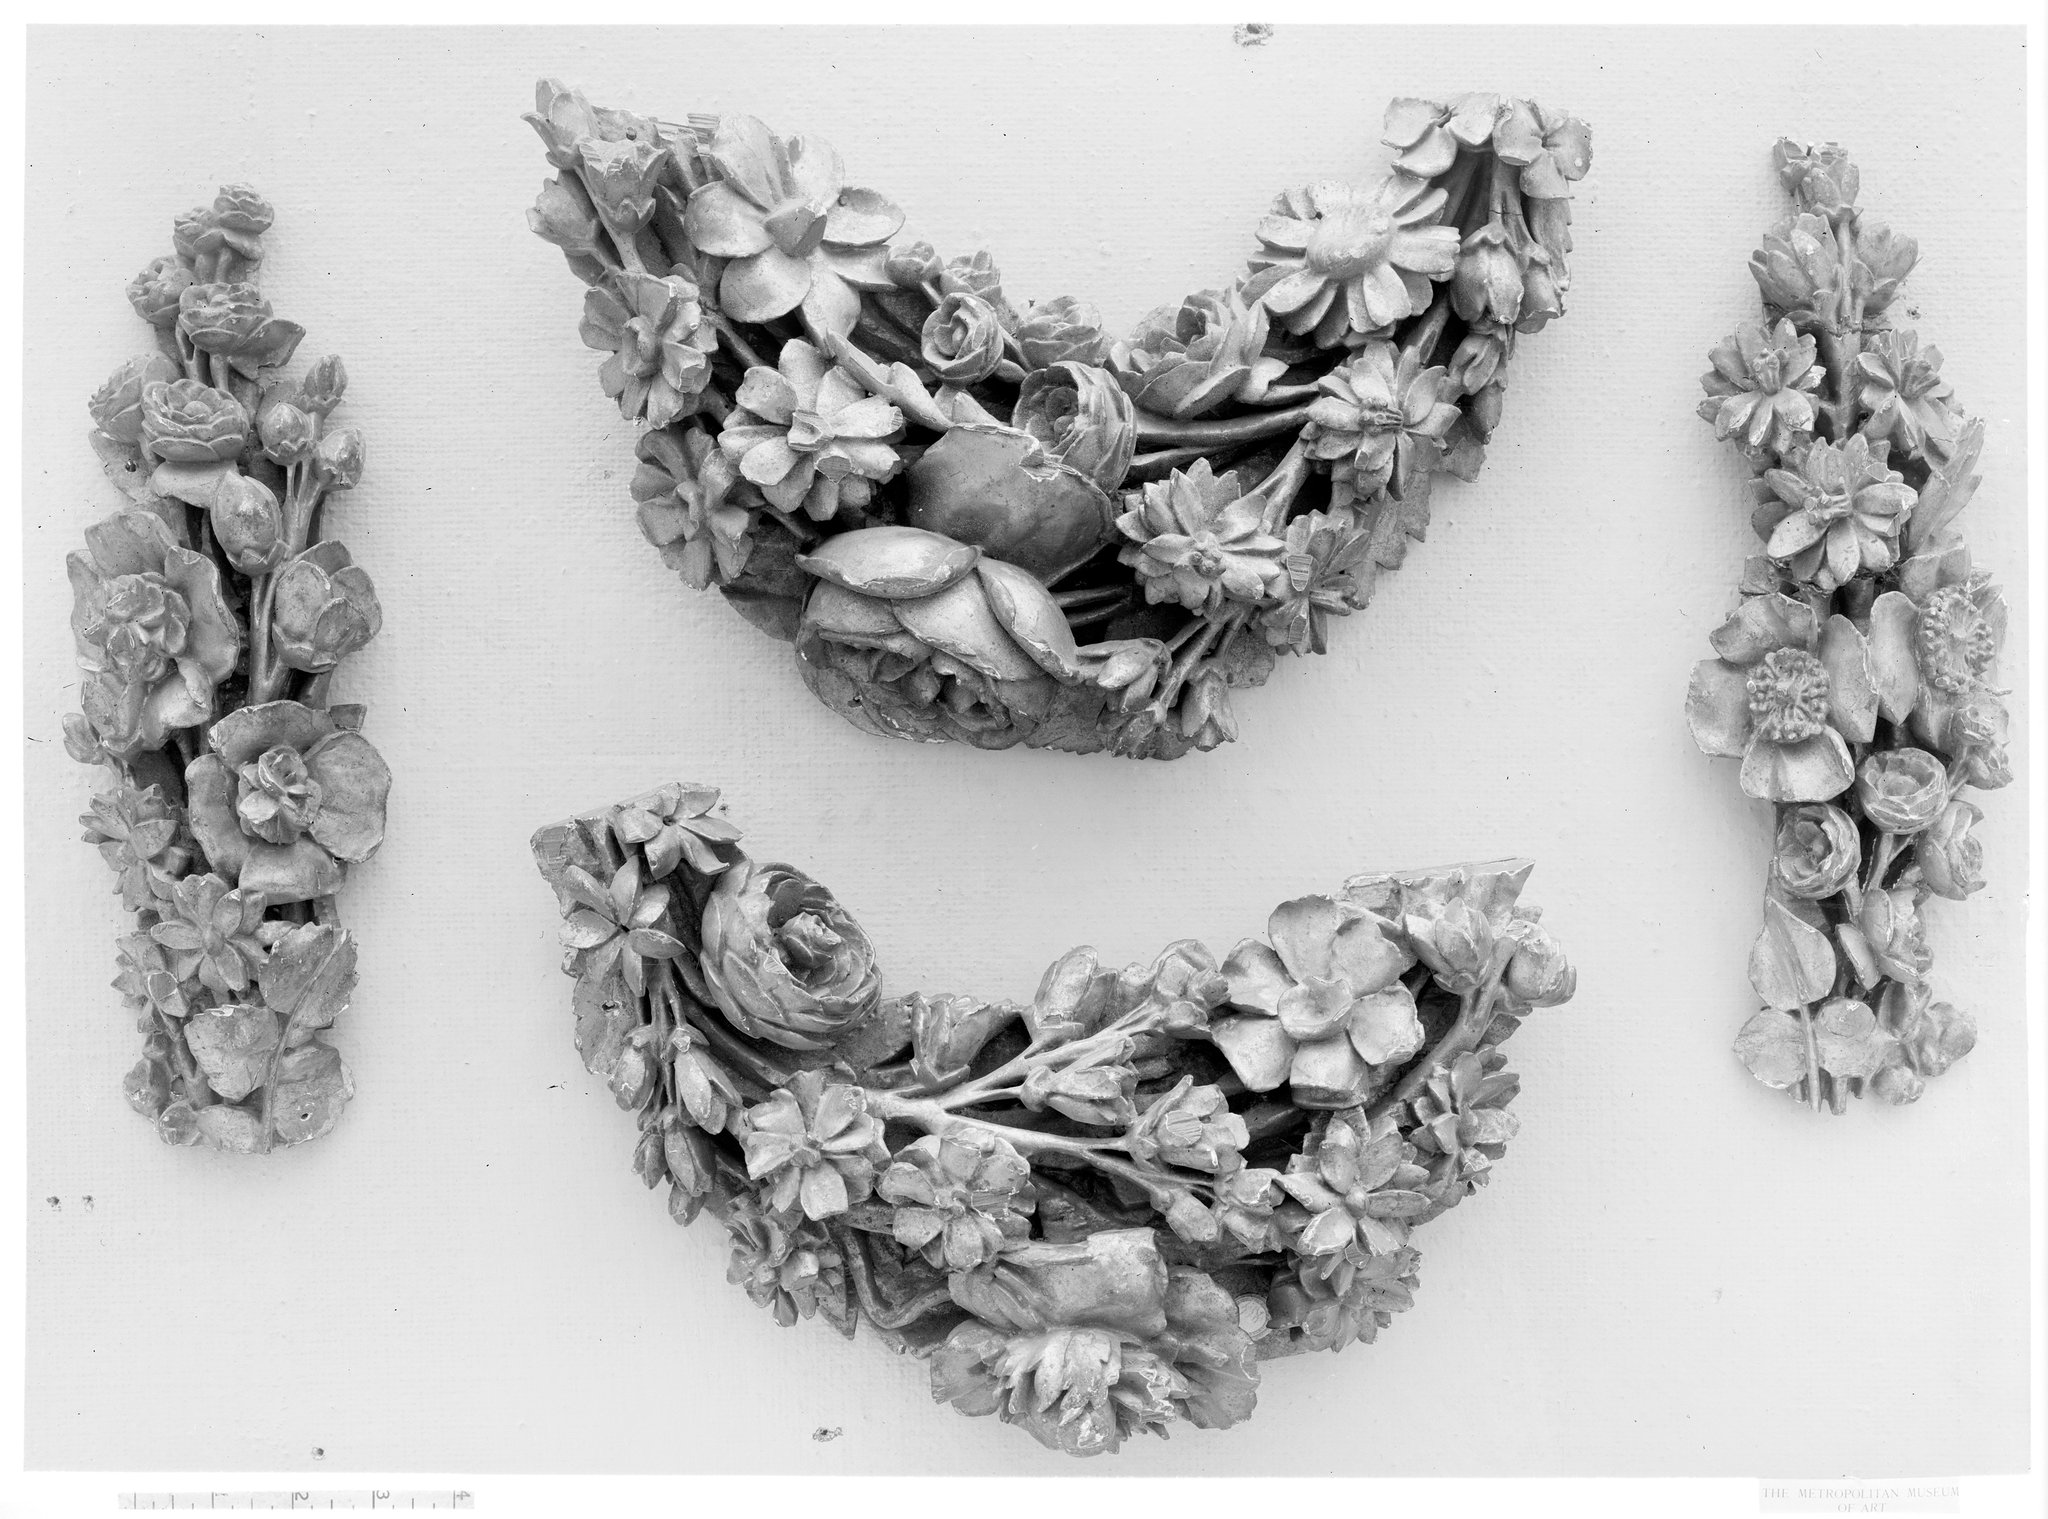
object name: pendant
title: Pendant (part of a set)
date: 1701-1800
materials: gilt, wood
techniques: carving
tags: flowers,leaves